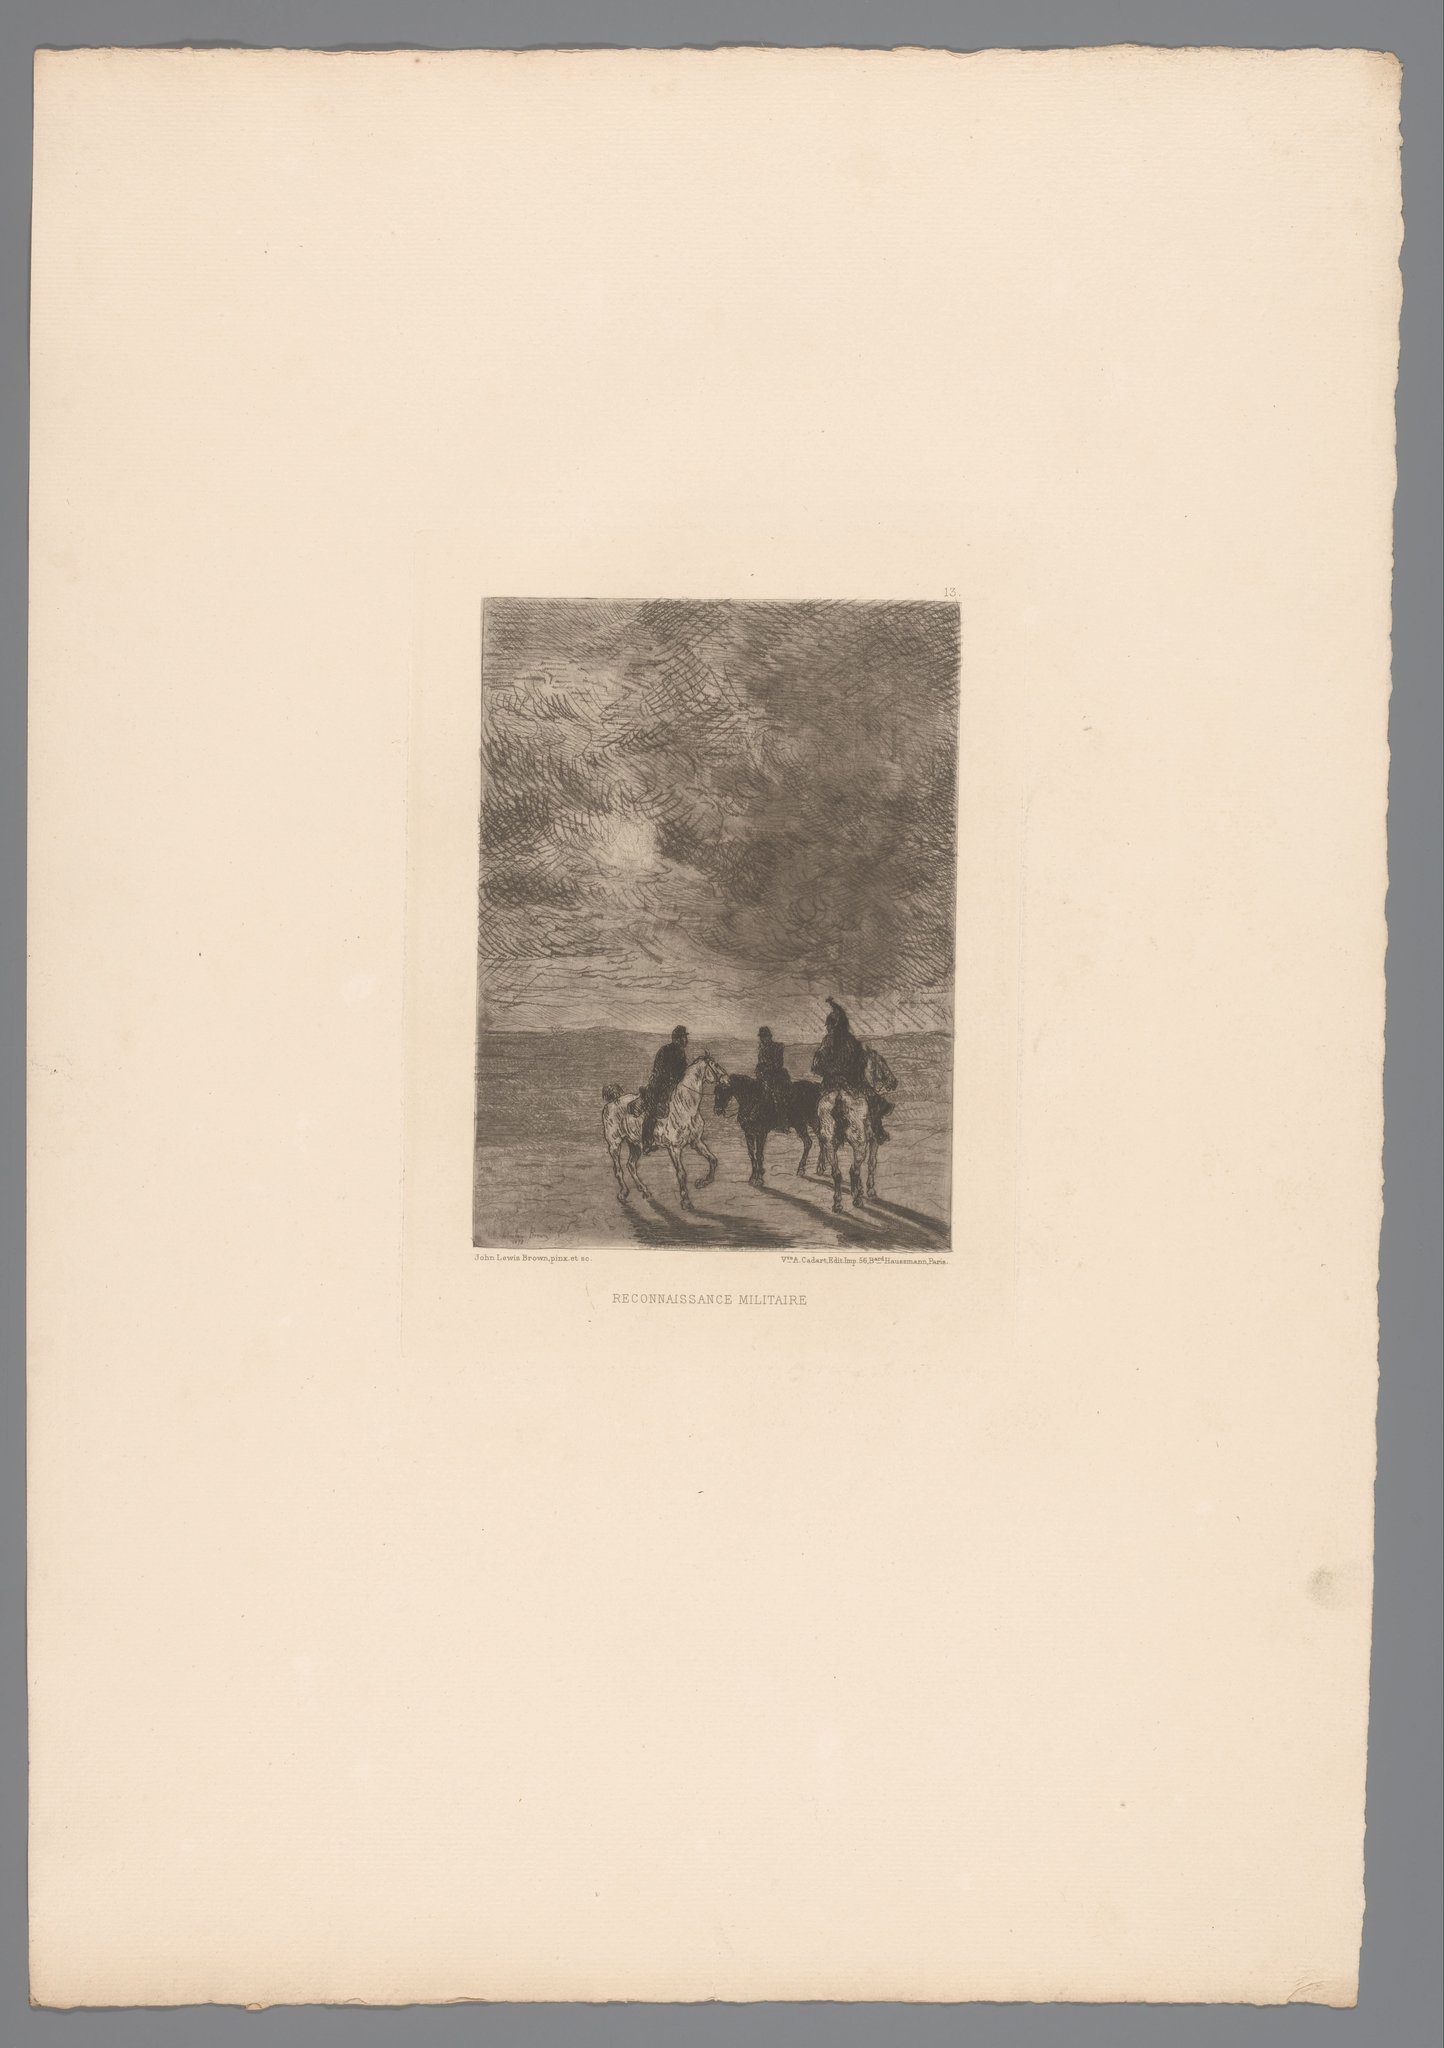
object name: print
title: L'eau-forte en 1879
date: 1879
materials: paper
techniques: drypoint, etching, intaglio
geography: paris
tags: animals used in the army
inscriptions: collector's mark: Lugt 2760, collector's mark: Lugt 2228, collector's mark: ‘AFE v S’